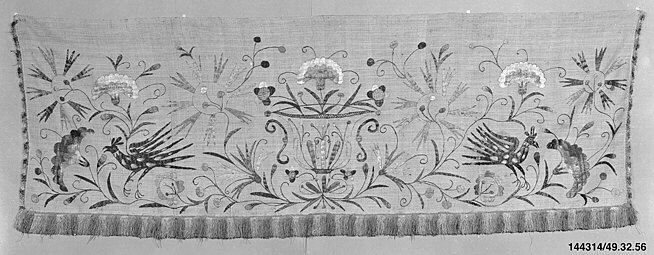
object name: border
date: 1701-1800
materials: linen, silk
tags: birds,flowers